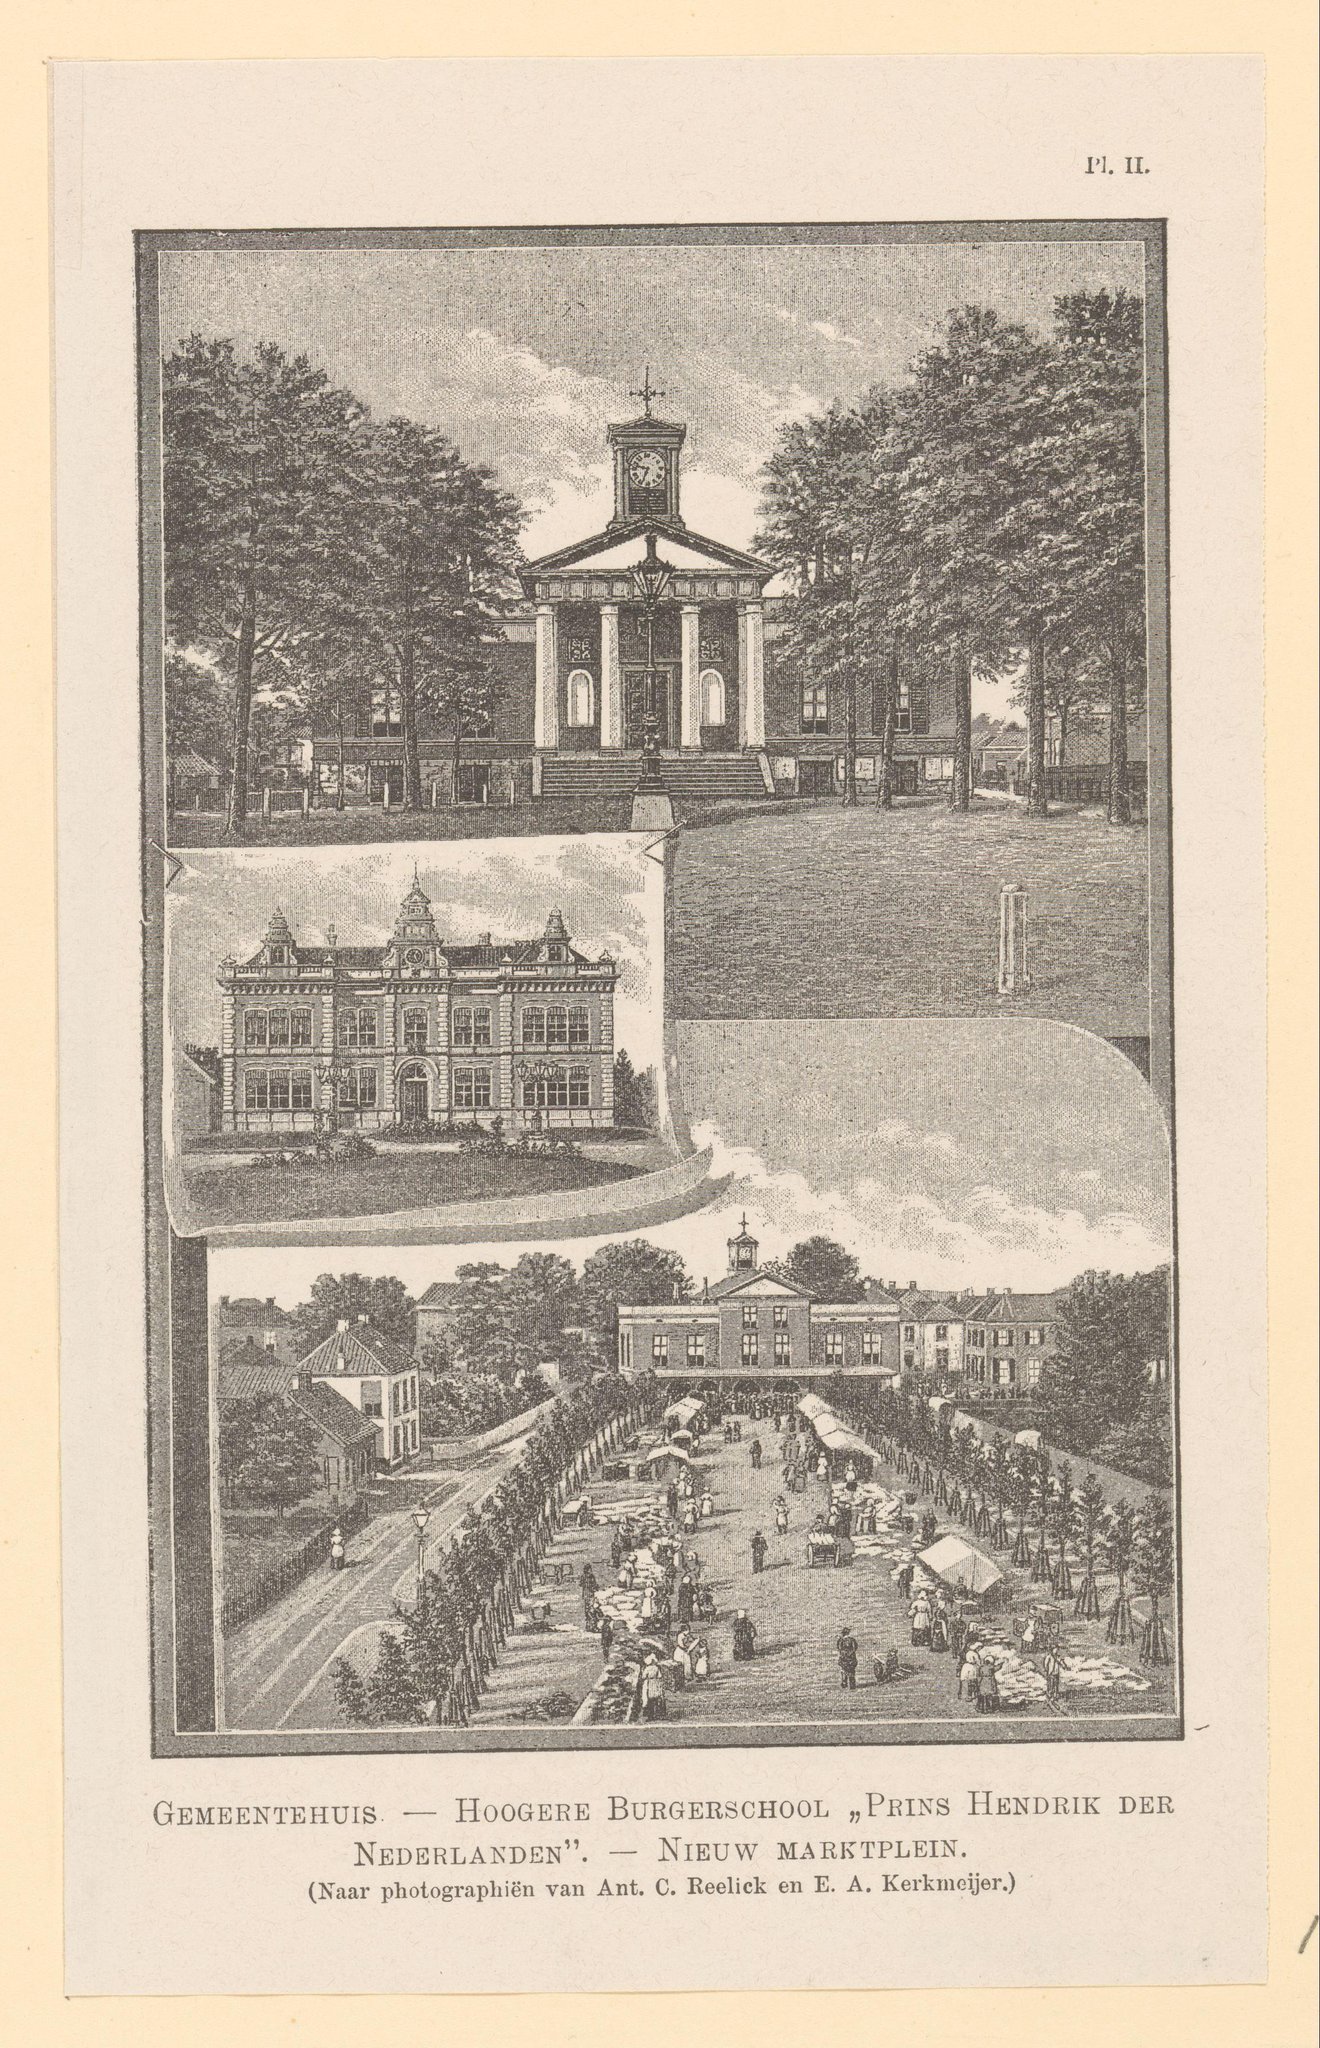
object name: photomechanical print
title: Gezichten op Apeldoorn en omstreken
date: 1890-1900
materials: paper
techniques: autotype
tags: village street, townhall, market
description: Prent mogelijk uit: Gids voor Apeldoorn en omstreken. Apeldoorn: Vereeniging tot veraangenaming van het verblijf te Apeldoorn, [1891-1897].